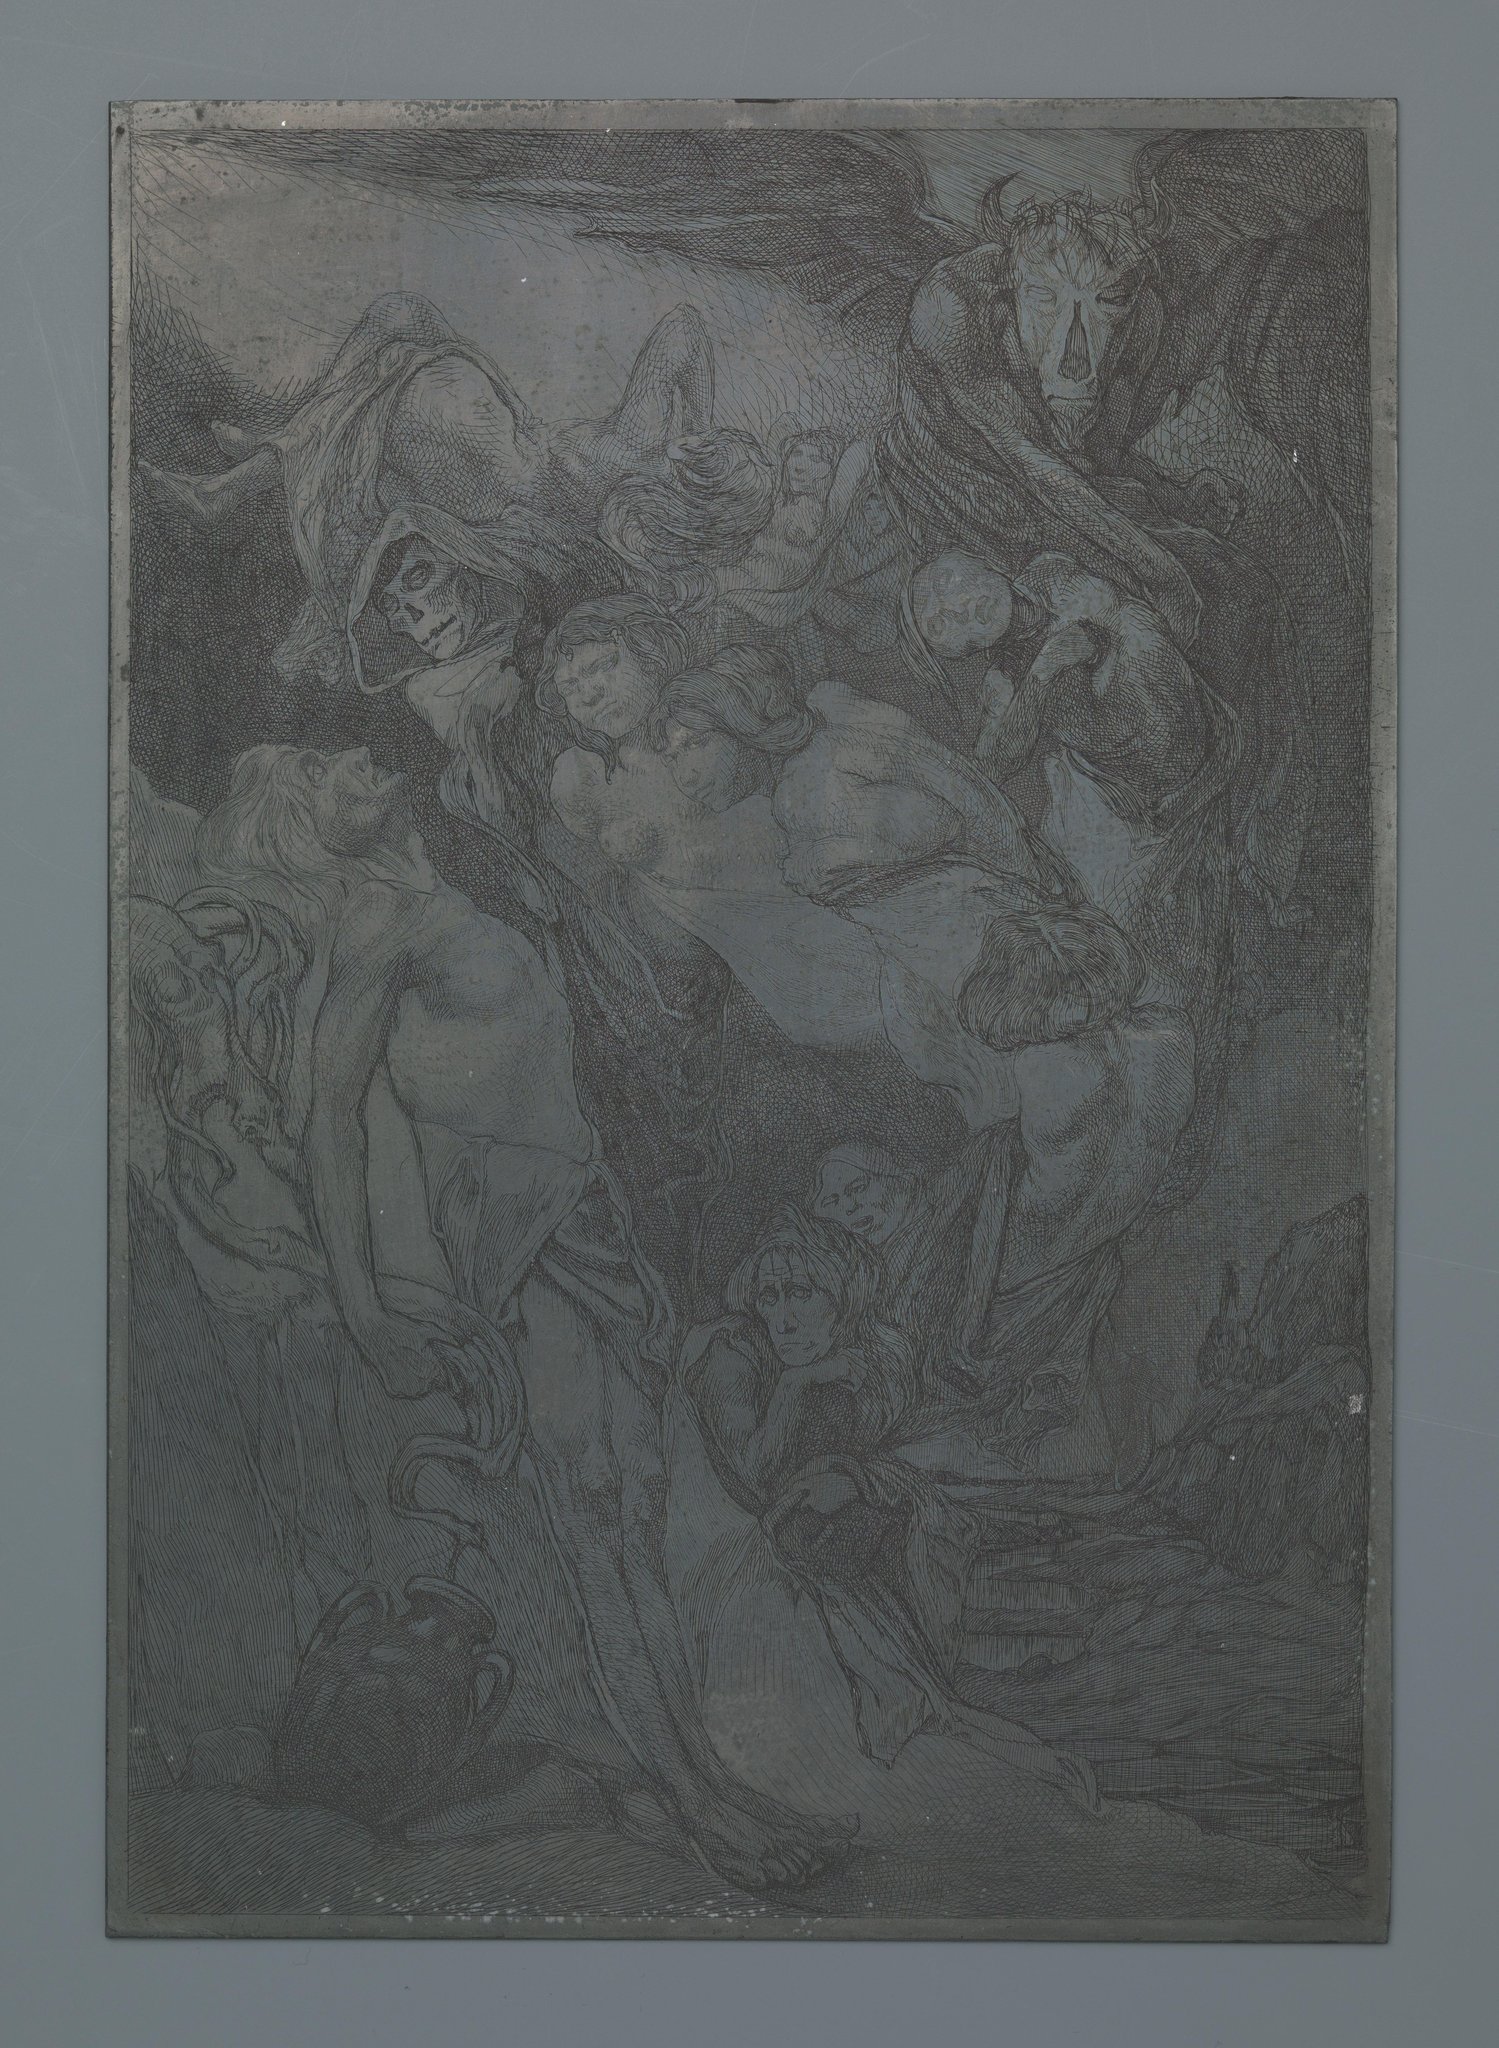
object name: zinkplaat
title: De dood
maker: johannes josephus aarts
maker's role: draughtsman, print maker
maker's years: 1871-1934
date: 1881-1934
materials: zinc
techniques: etching